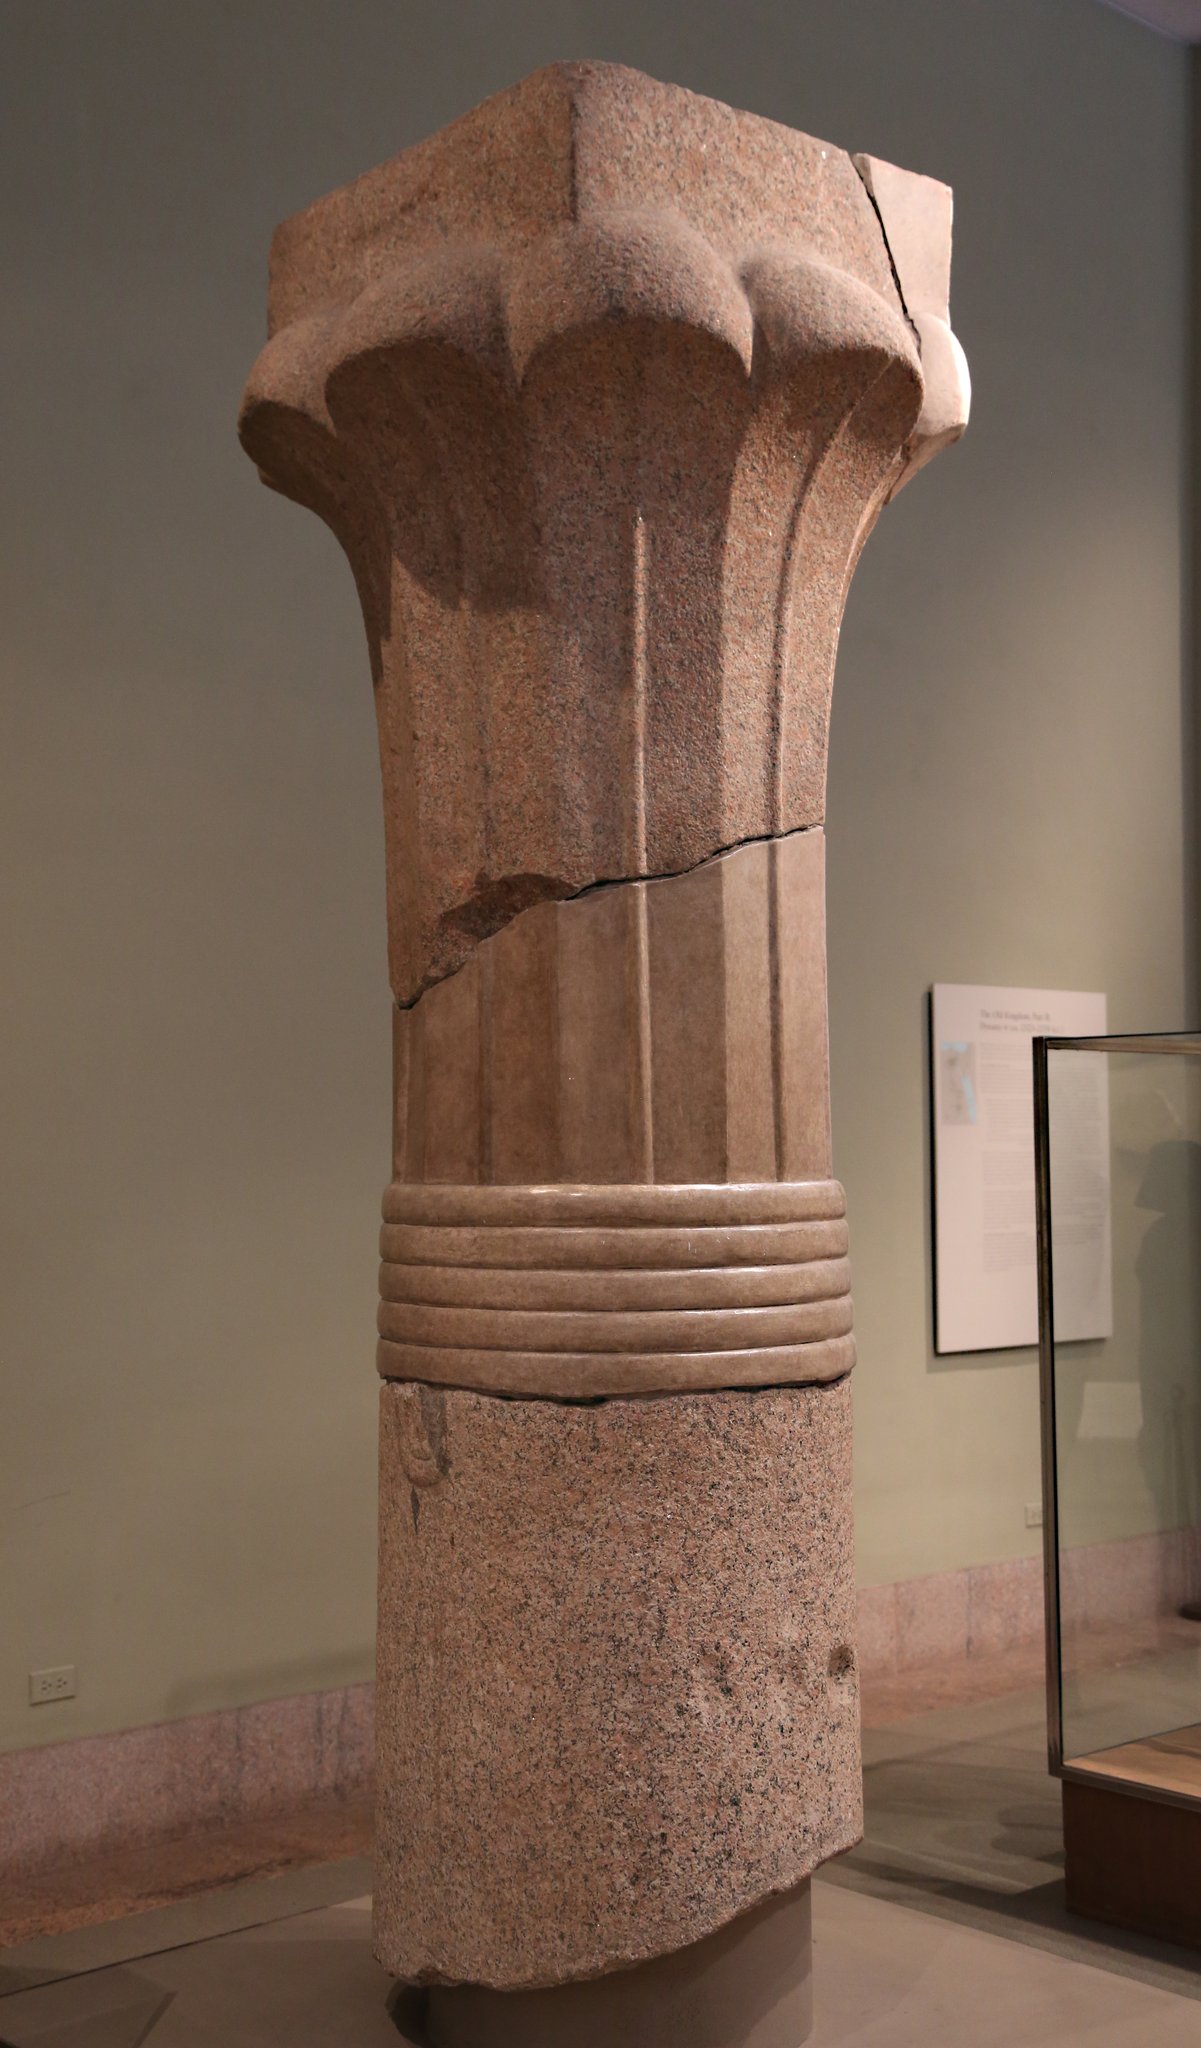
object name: column, capital, unis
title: Fragments of a Palm Column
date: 2353-2323 BCE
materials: granite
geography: memphite region